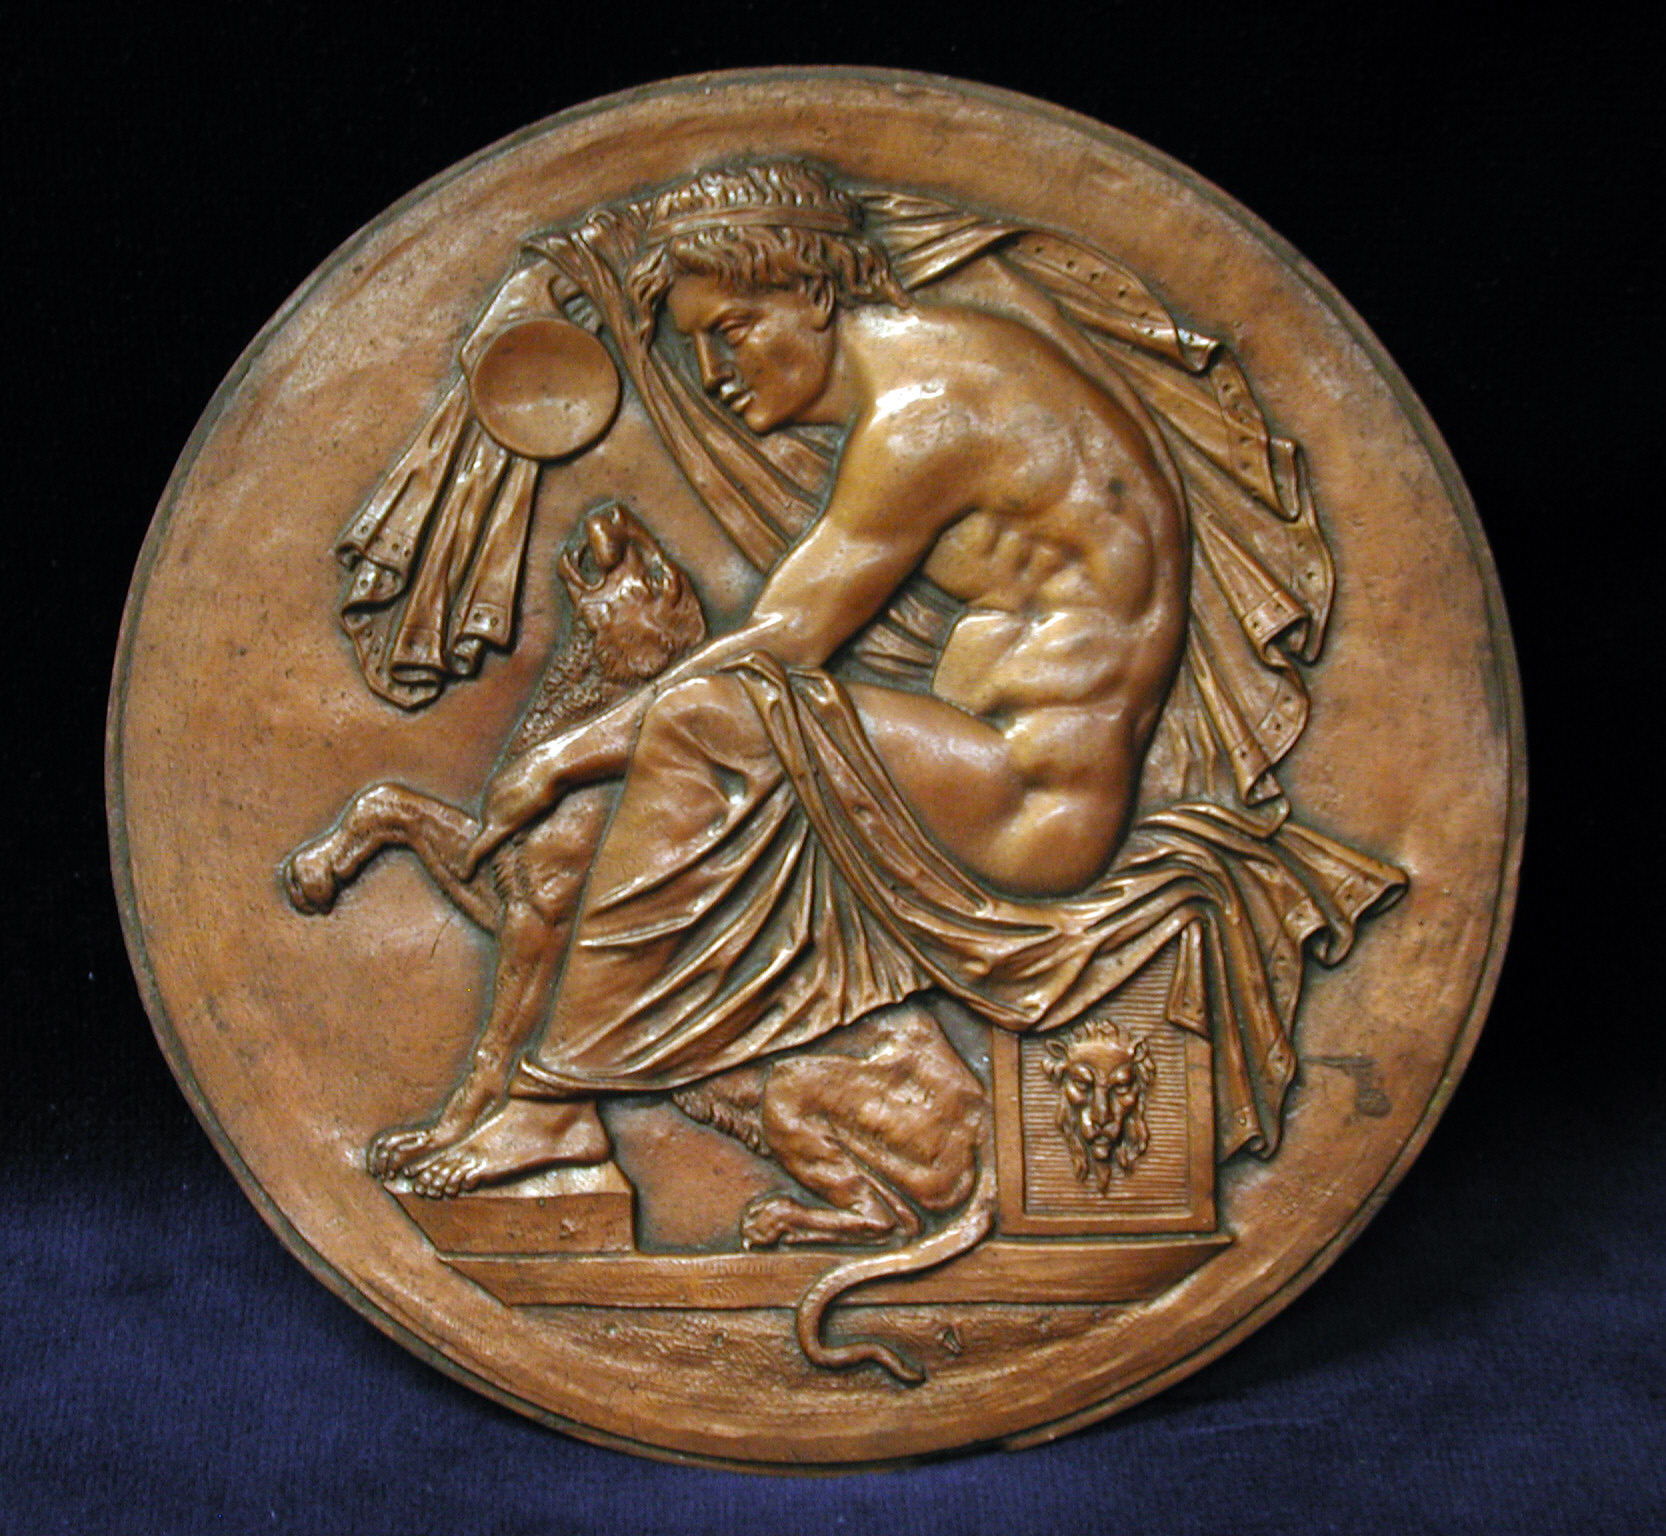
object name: medallion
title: Man with a dog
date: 1801-1900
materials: copper, lead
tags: men,dogs